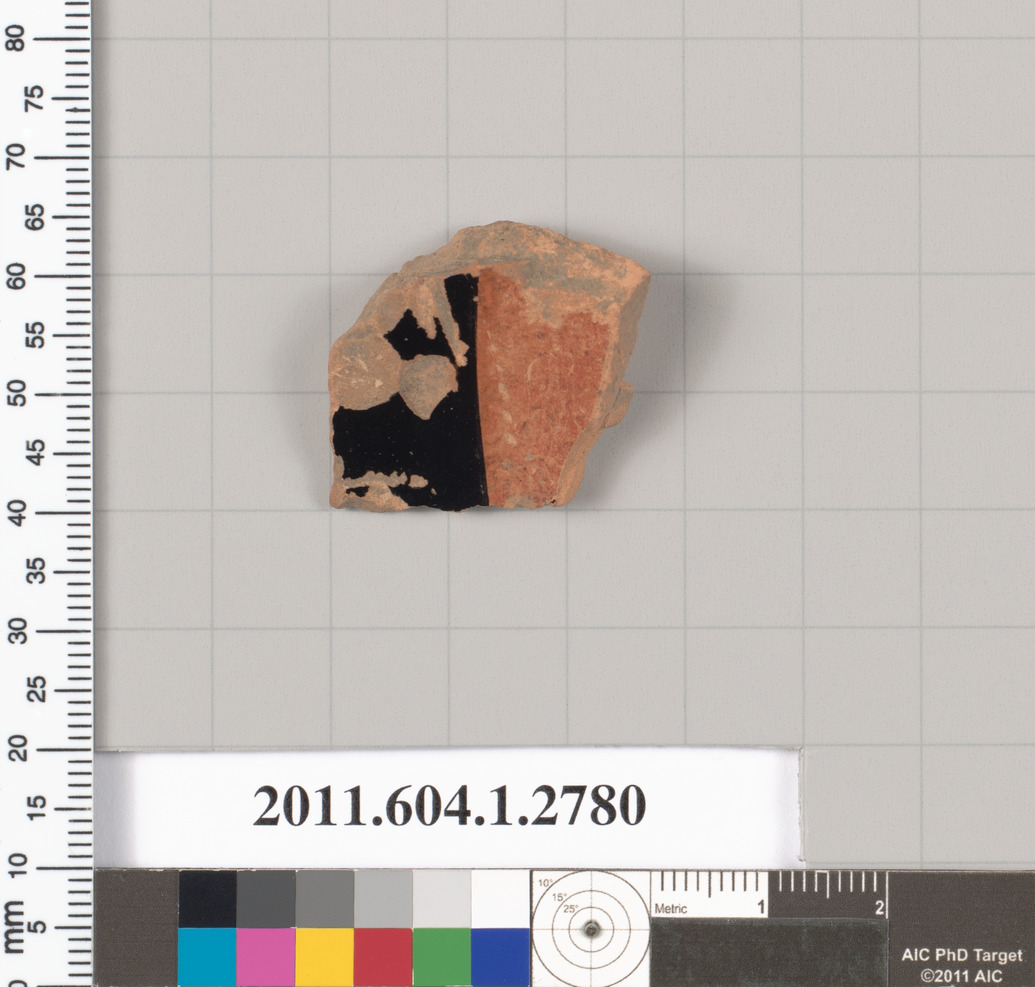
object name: kylix fragment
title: Terracotta fragment of a kylix (drinking cup)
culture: greek, attic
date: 475-451 BCE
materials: terracotta